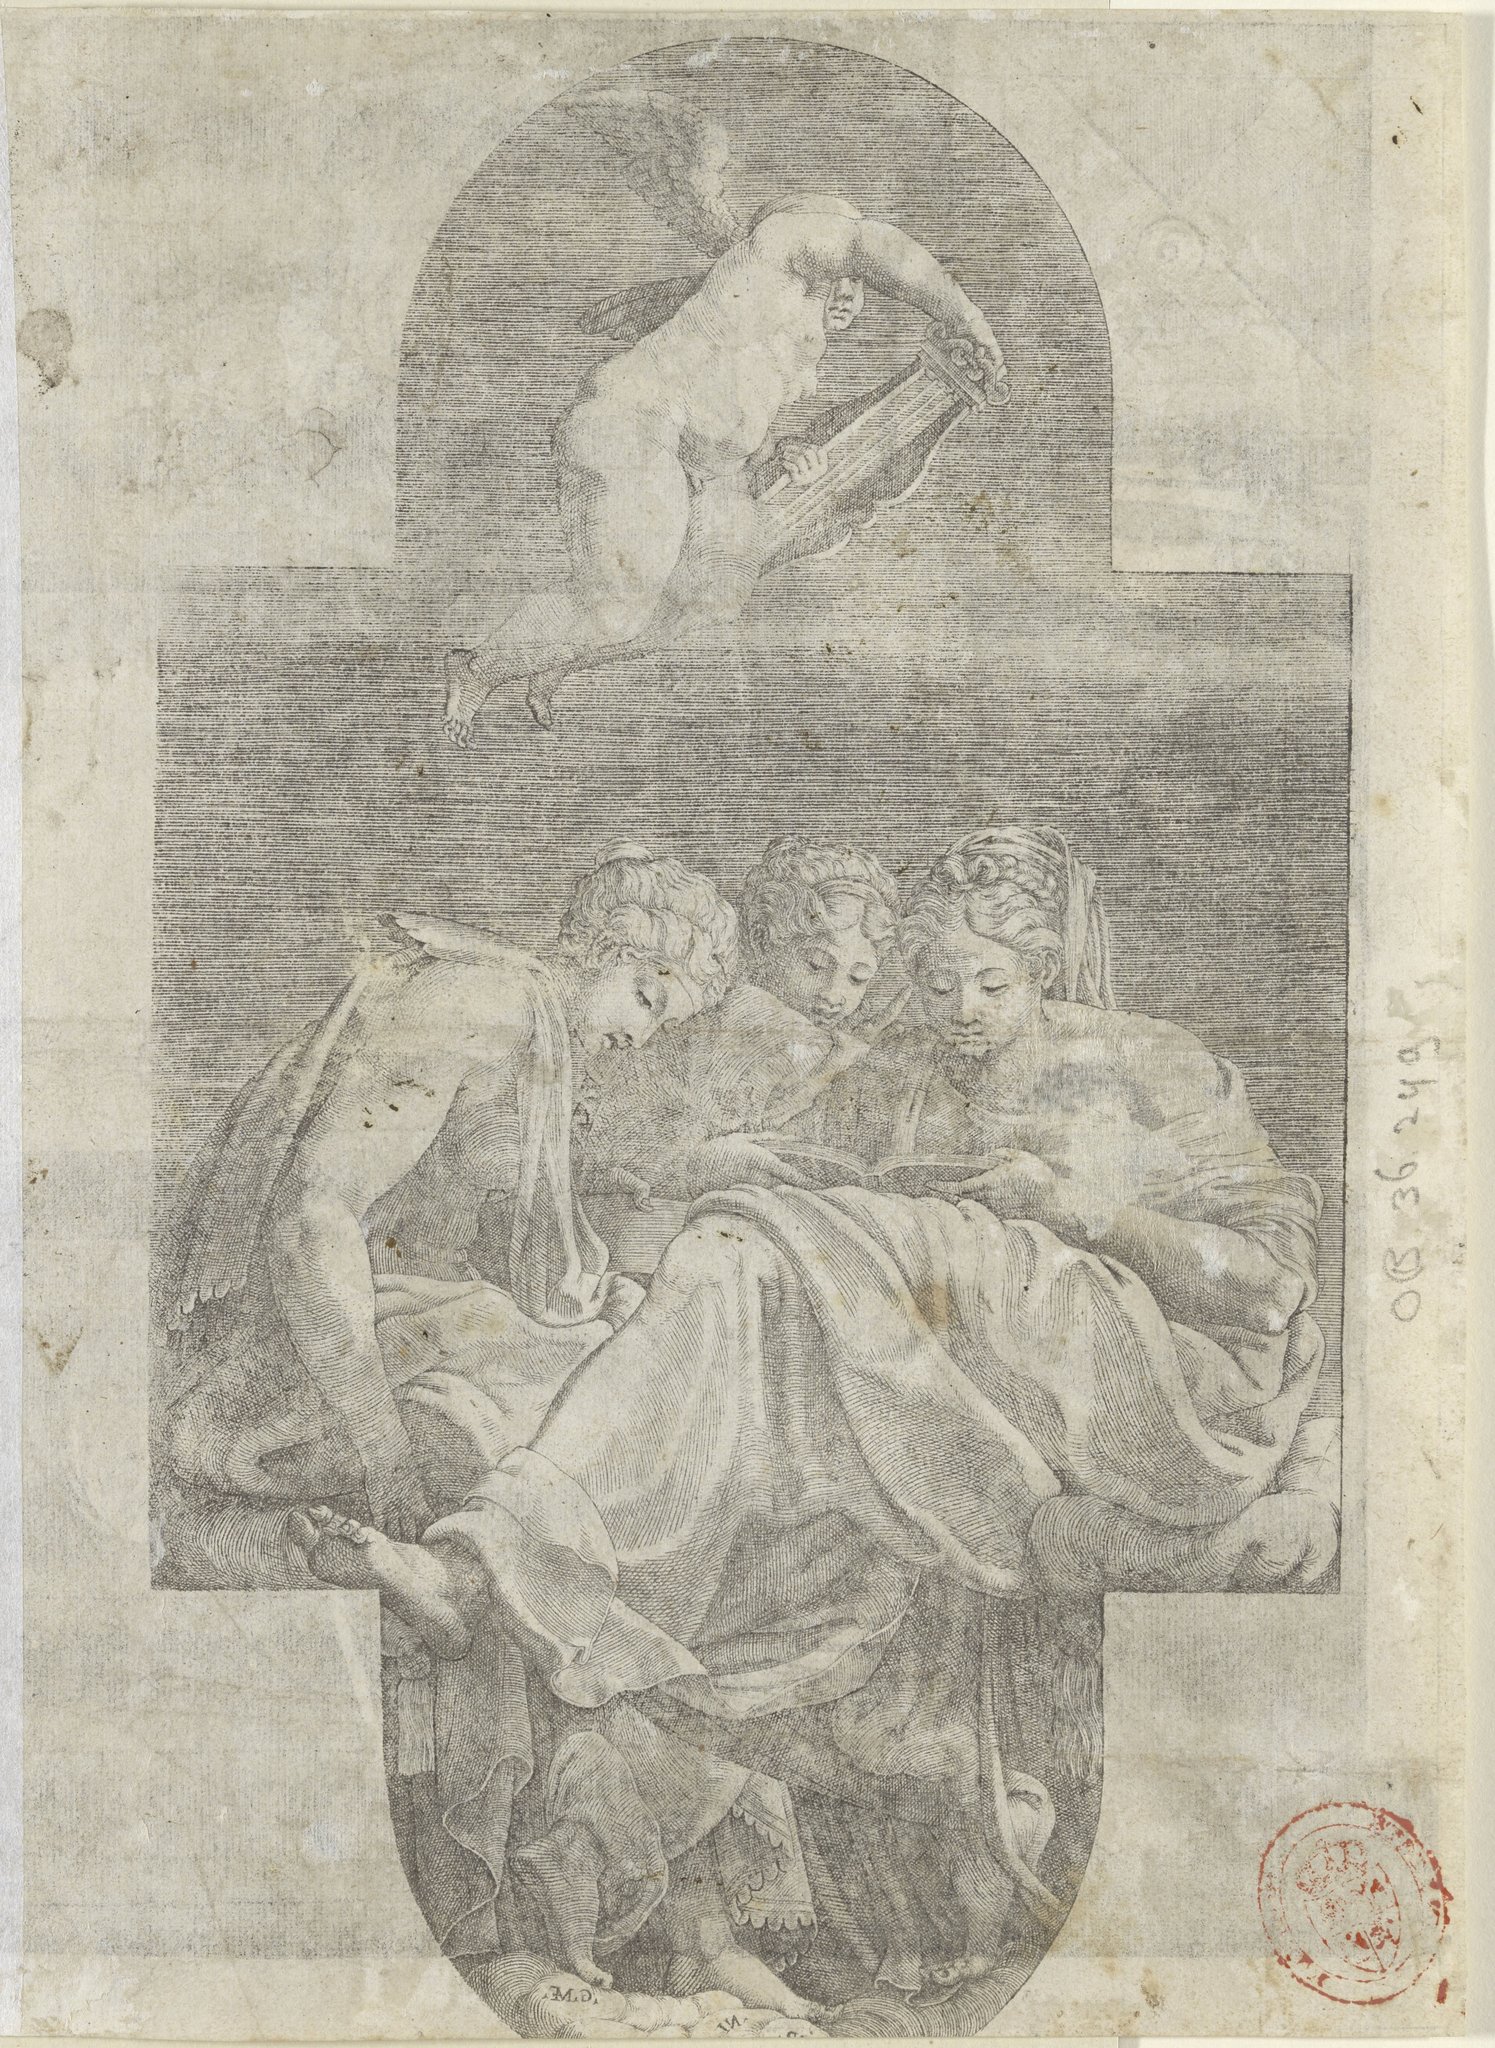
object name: print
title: Plafondschilderingen in de Galerie d'Ulysse te Fontainebleau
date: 1530-1582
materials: paper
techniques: printmaking, engraving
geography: fontainebleau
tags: lyre, cithara, psaltery, the muses acting together (as group), cupids: 'amores', 'amoretti', 'putti'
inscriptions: collector's mark: Lugt 240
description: Prent uit een reeks van vier prenten naar plafondschilderingen in de Galerie d'Ulysse te Fontainebleau, door Francesco Primaticcio.